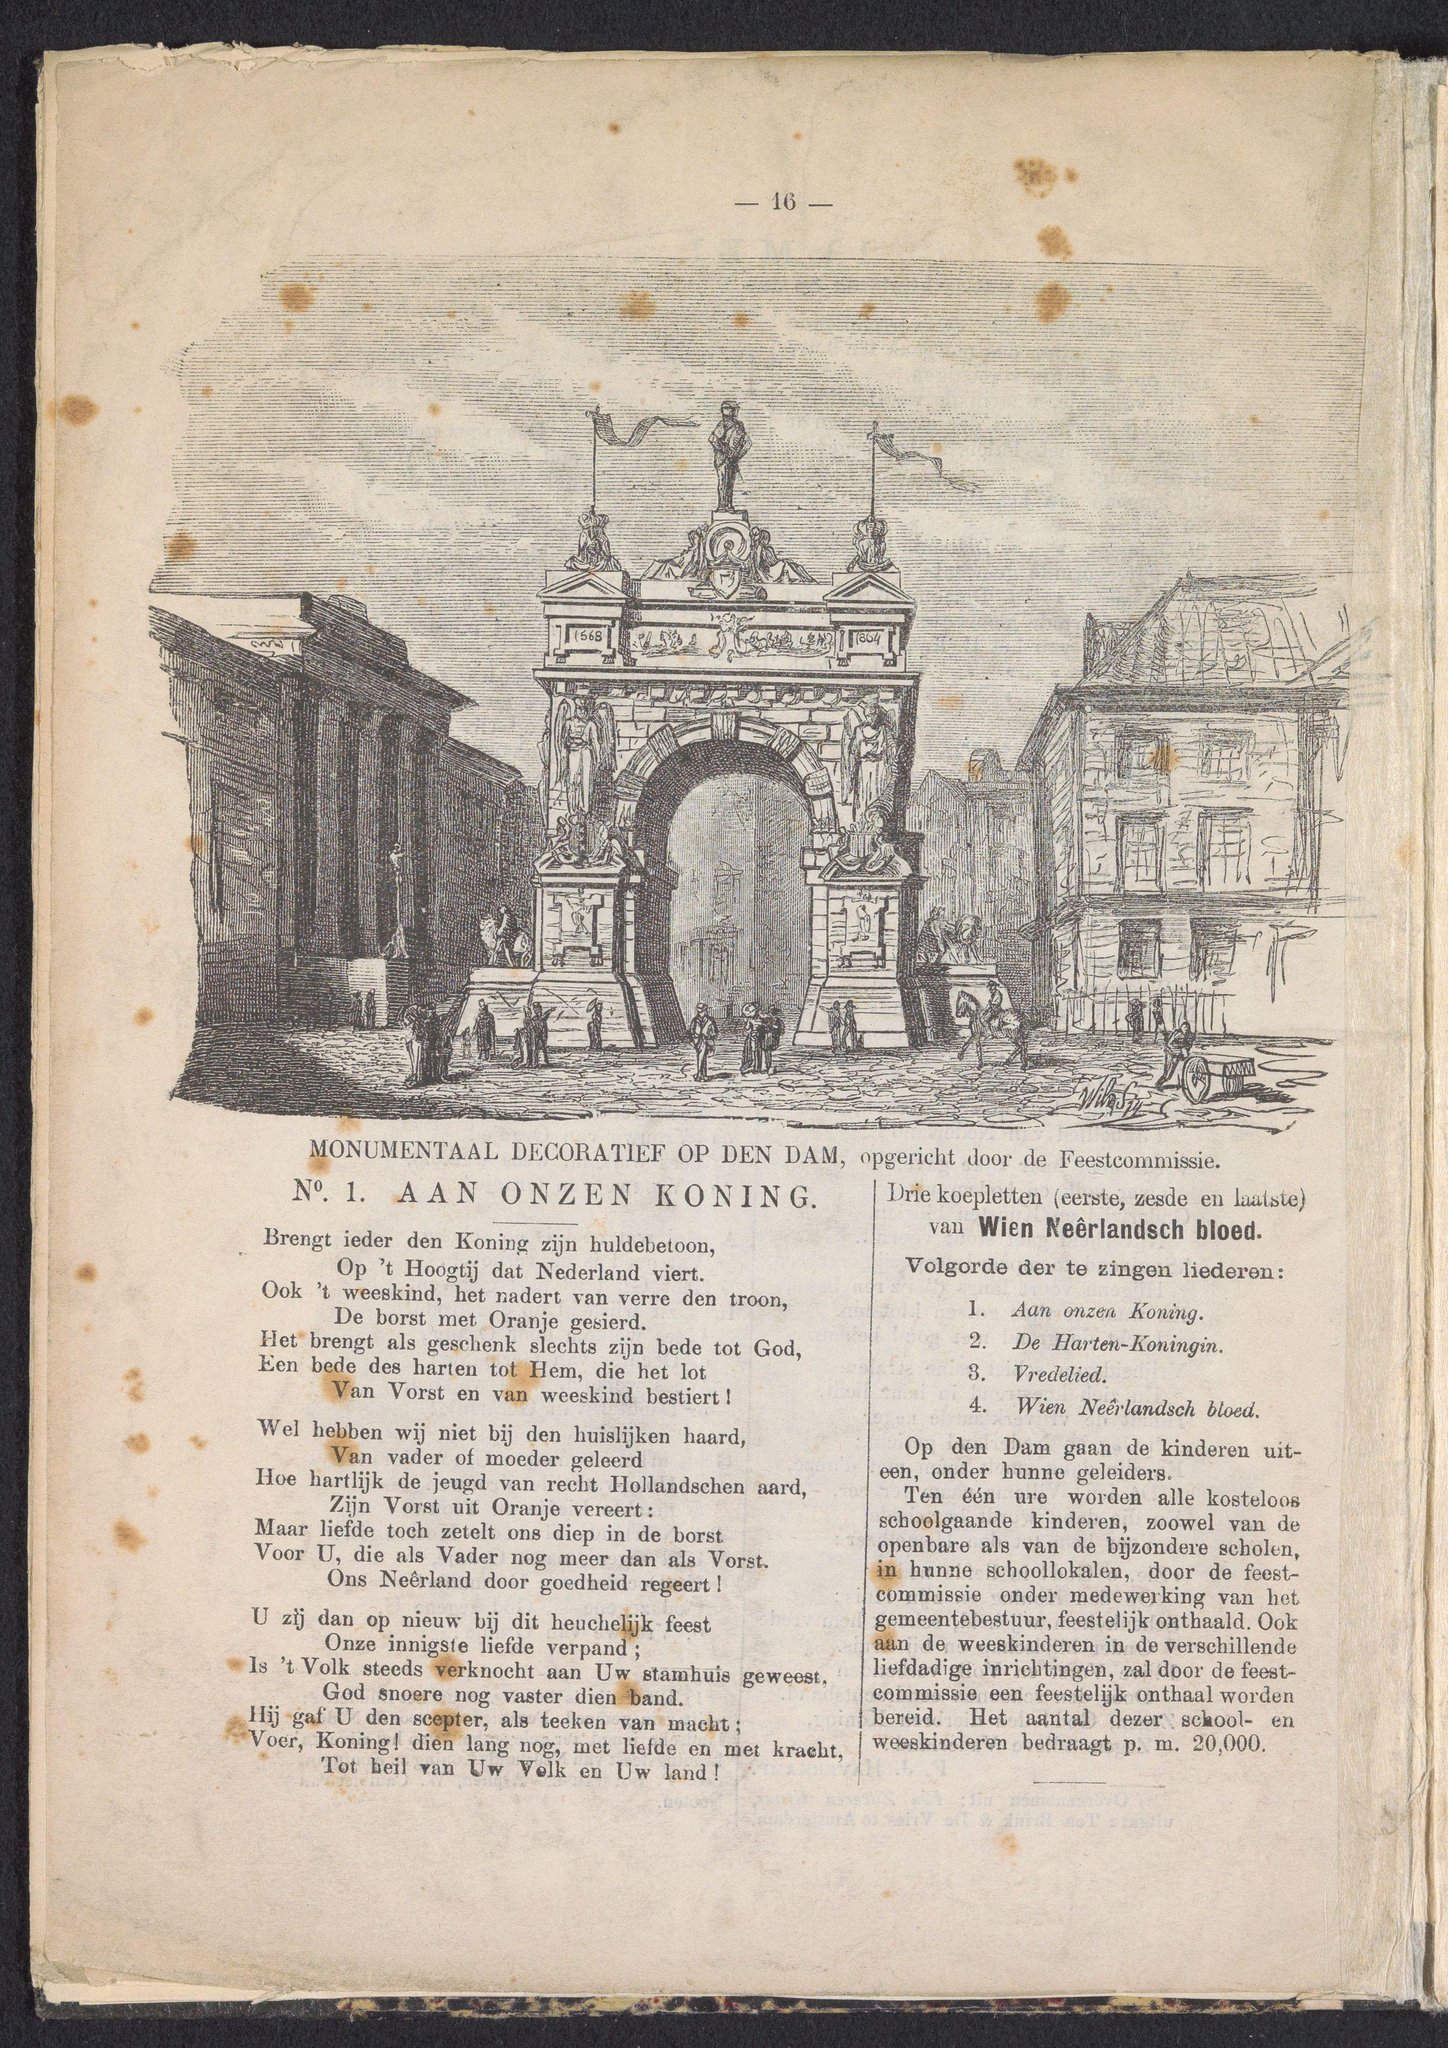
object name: book illustration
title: Erepoort op de Dam, bij het 25-jarige jubileum van de inhuldiging van koning Willem III te Amsterdam, 1874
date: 1874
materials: paper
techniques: letterpress printing, engraving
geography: amsterdam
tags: brussels, willem iii (koning der nederlanden), public festivities at other royal events, not meant or mentioned above (+ festive decoration ~ festive activities), amsterdam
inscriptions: date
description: Erepoort op de Dam. Illustratie in de officiële feestgids bij het 25-jarige jubileum van de inhuldiging van koning Willem III te Amsterdam, 12 mei 1874.